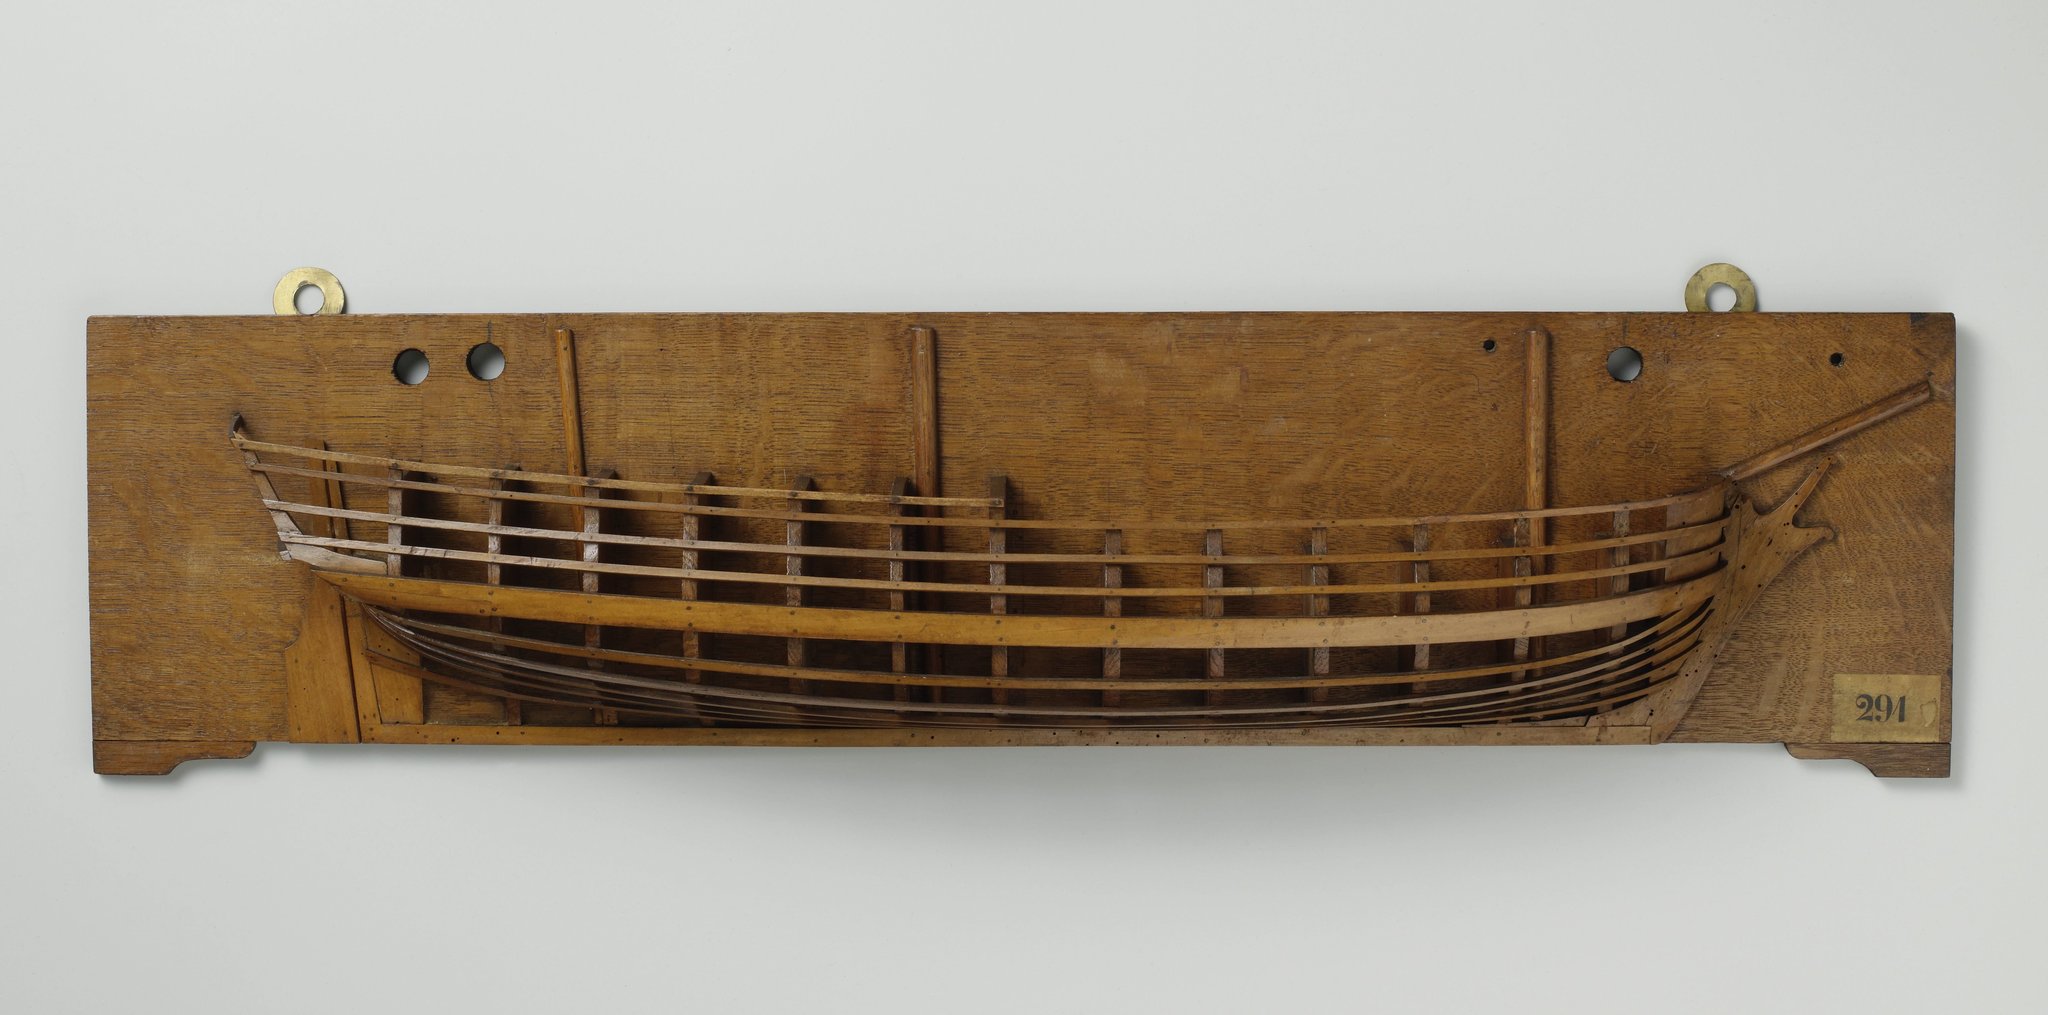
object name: builder's model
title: Half Model of a 36-Gun Frigate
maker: Anonymous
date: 1780-1825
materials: wood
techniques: polychromy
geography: netherlands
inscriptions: label, bottom right: ‘291’ former inventory label